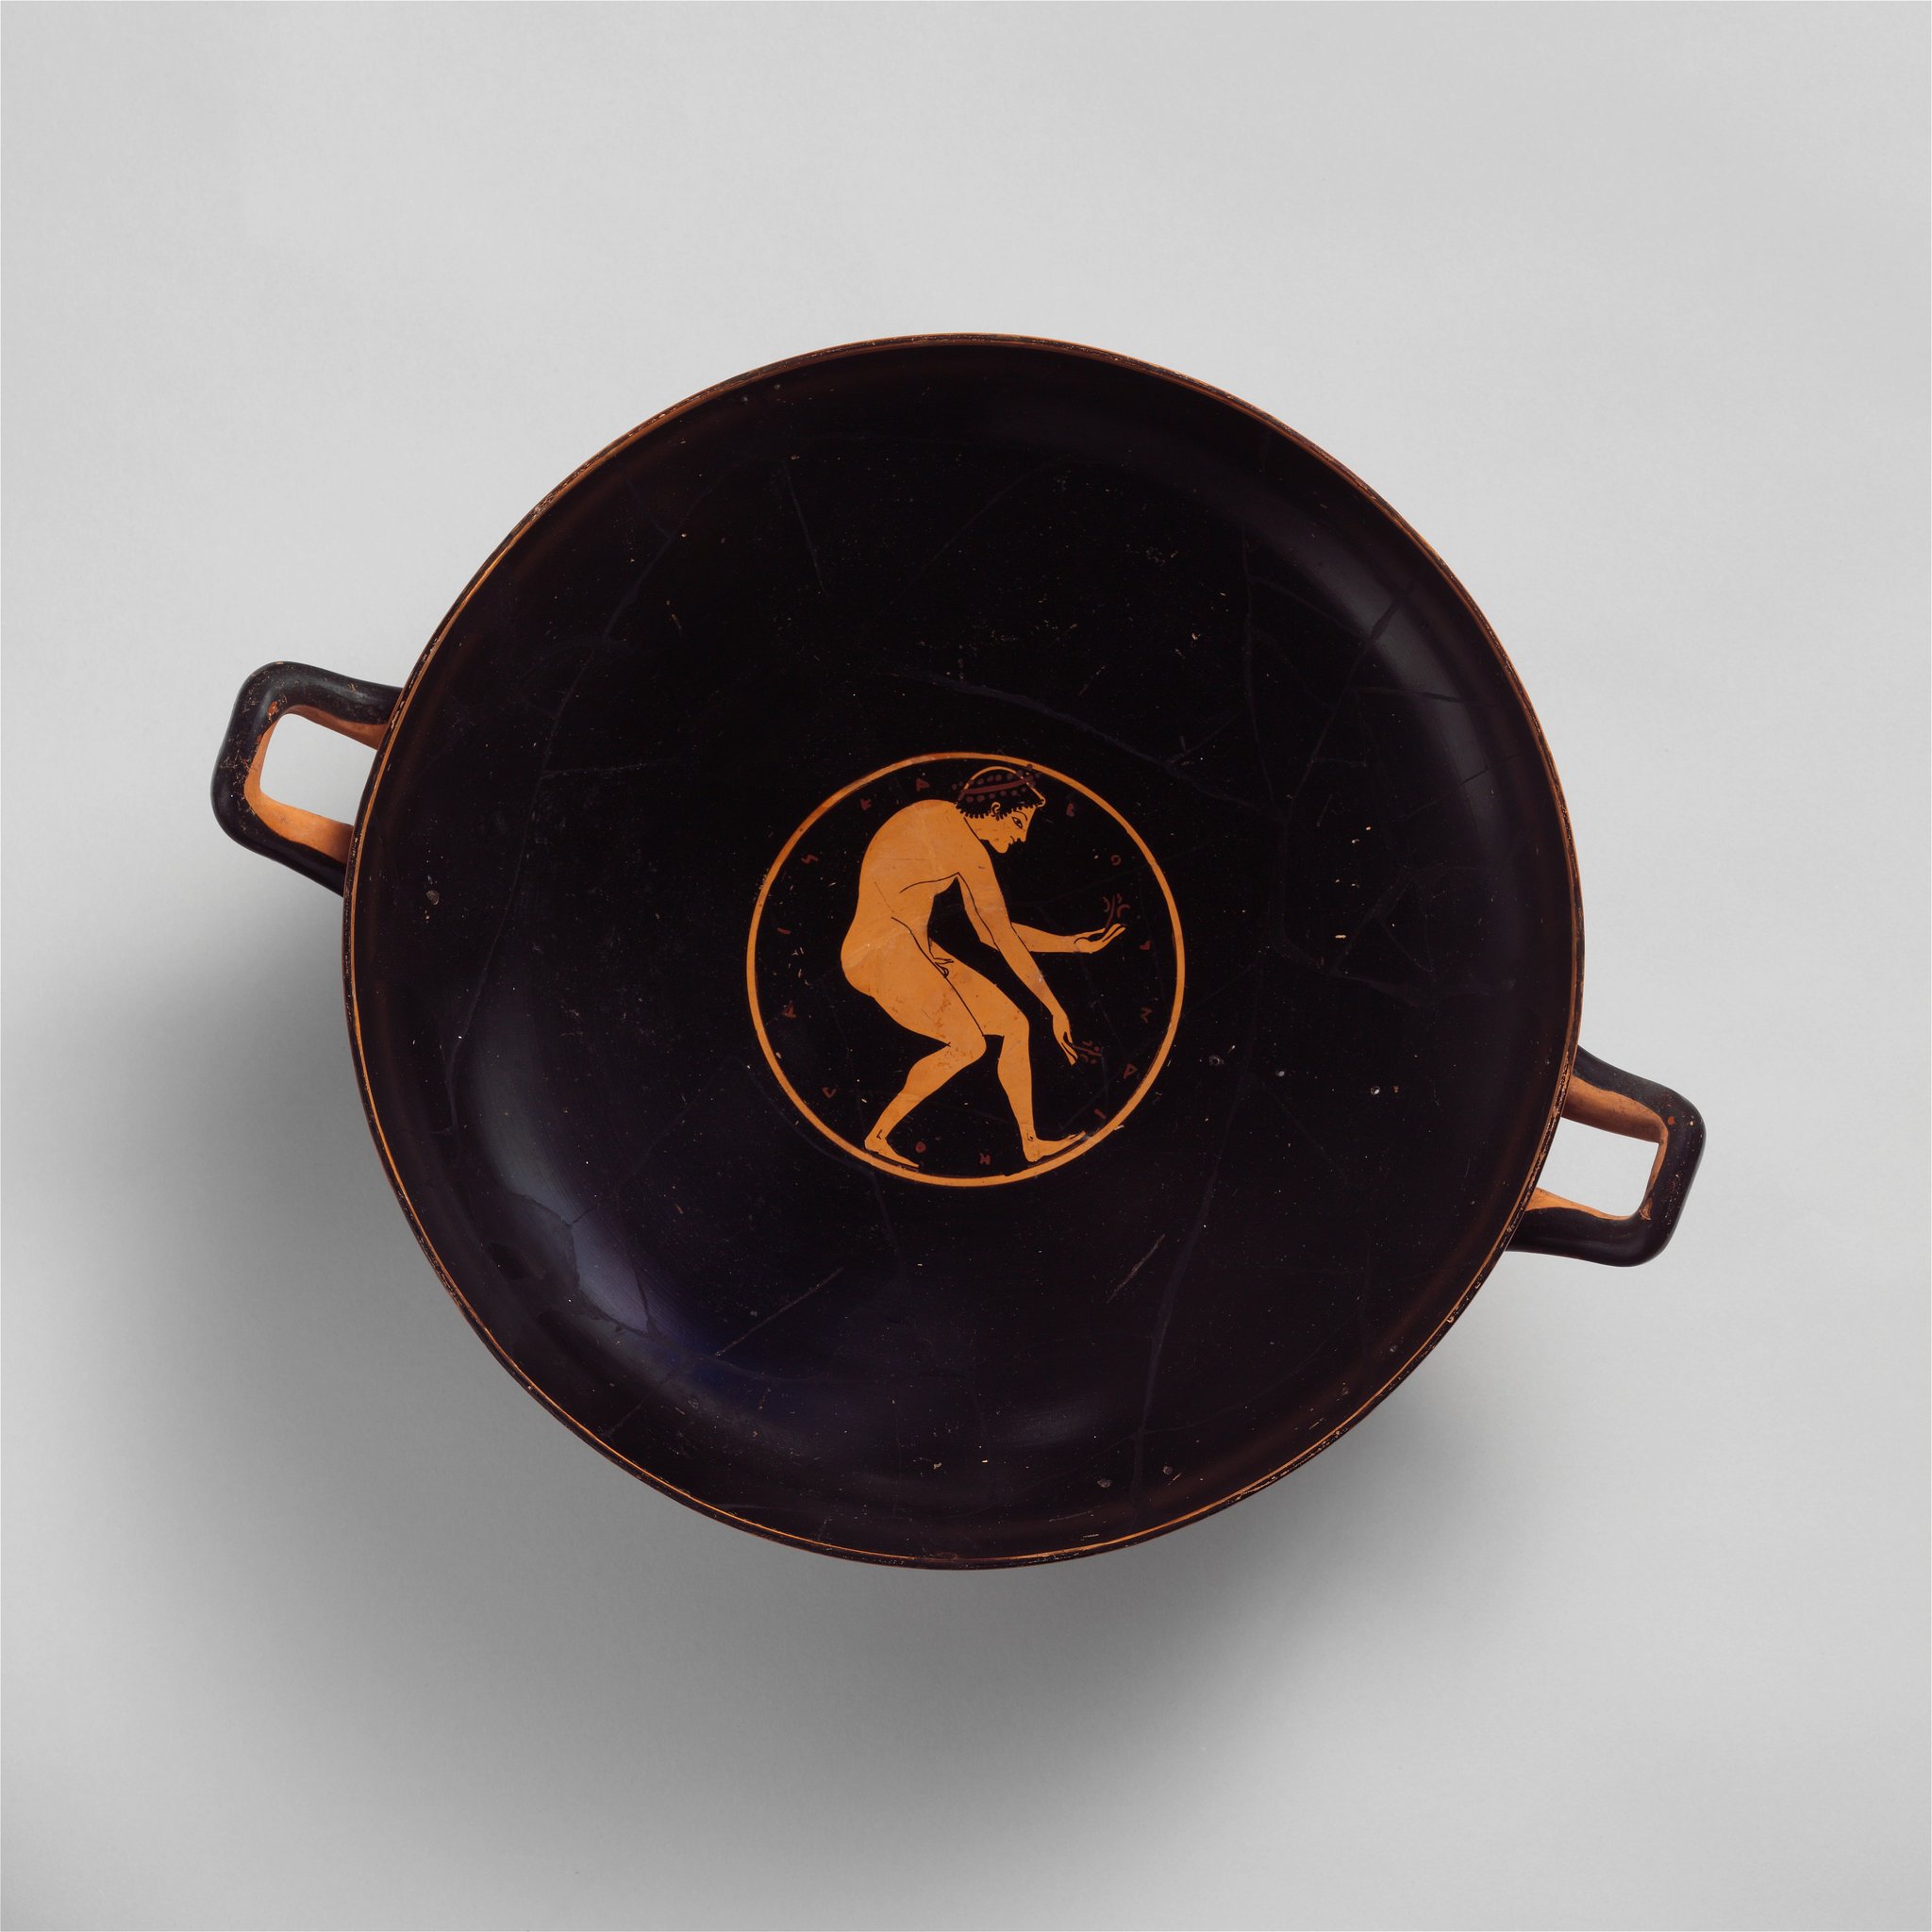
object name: kylix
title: Terracotta kylix (drinking cup)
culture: greek, attic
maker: euergides painter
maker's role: artist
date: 510 BCE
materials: terracotta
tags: male nudes,athletes